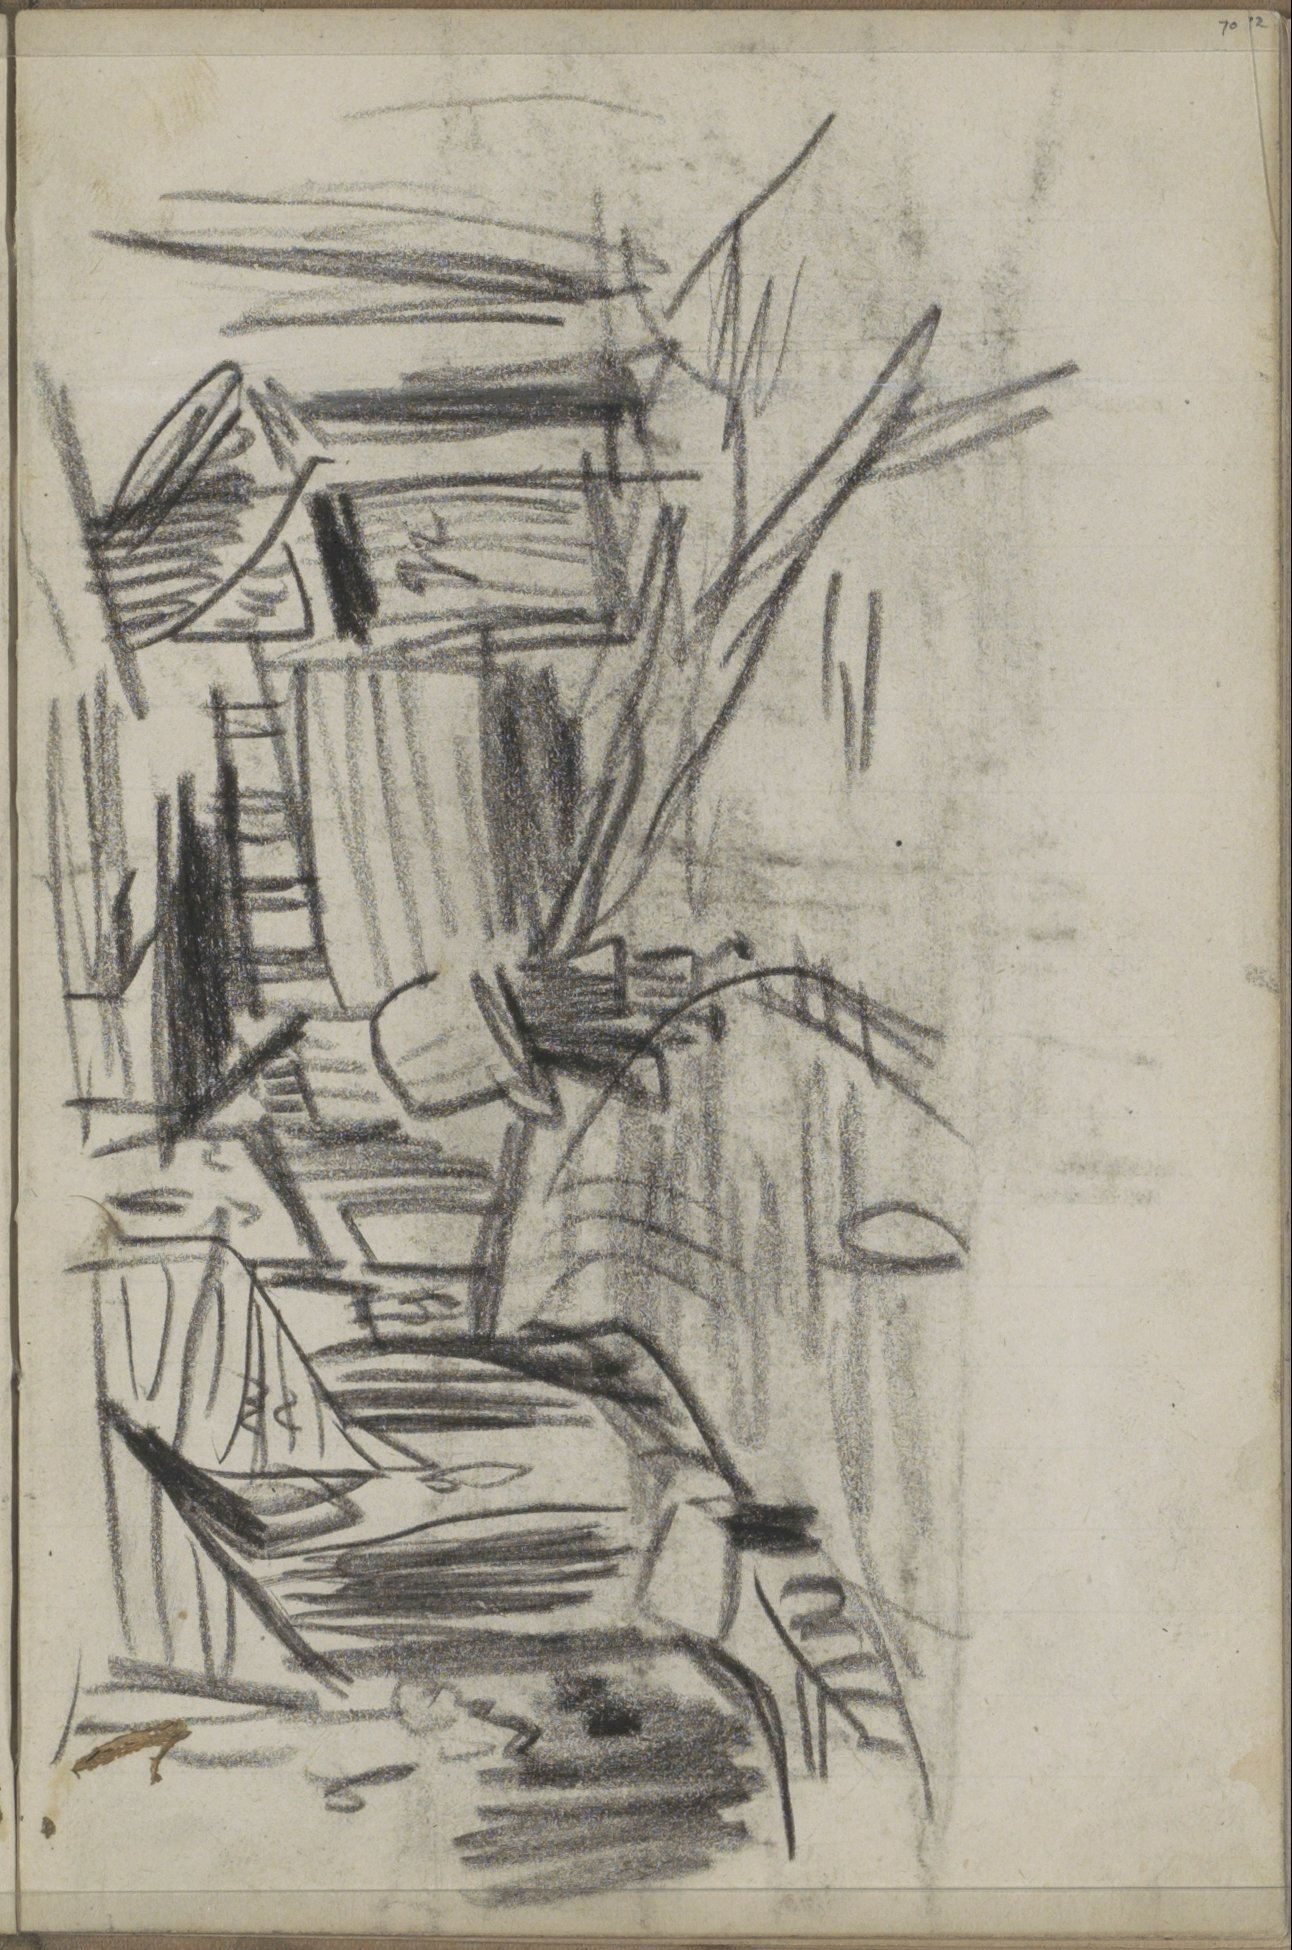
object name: sketchbook leaf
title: Straat met een lastdrager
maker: marius bauer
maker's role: draughtsman, print maker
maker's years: 1867-1932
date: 1888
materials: chalk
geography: istanbul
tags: porter, bearer, street (+ city(-scape) with figures, staffage)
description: Pagina 70 uit een schetsboek met 56 bladen.